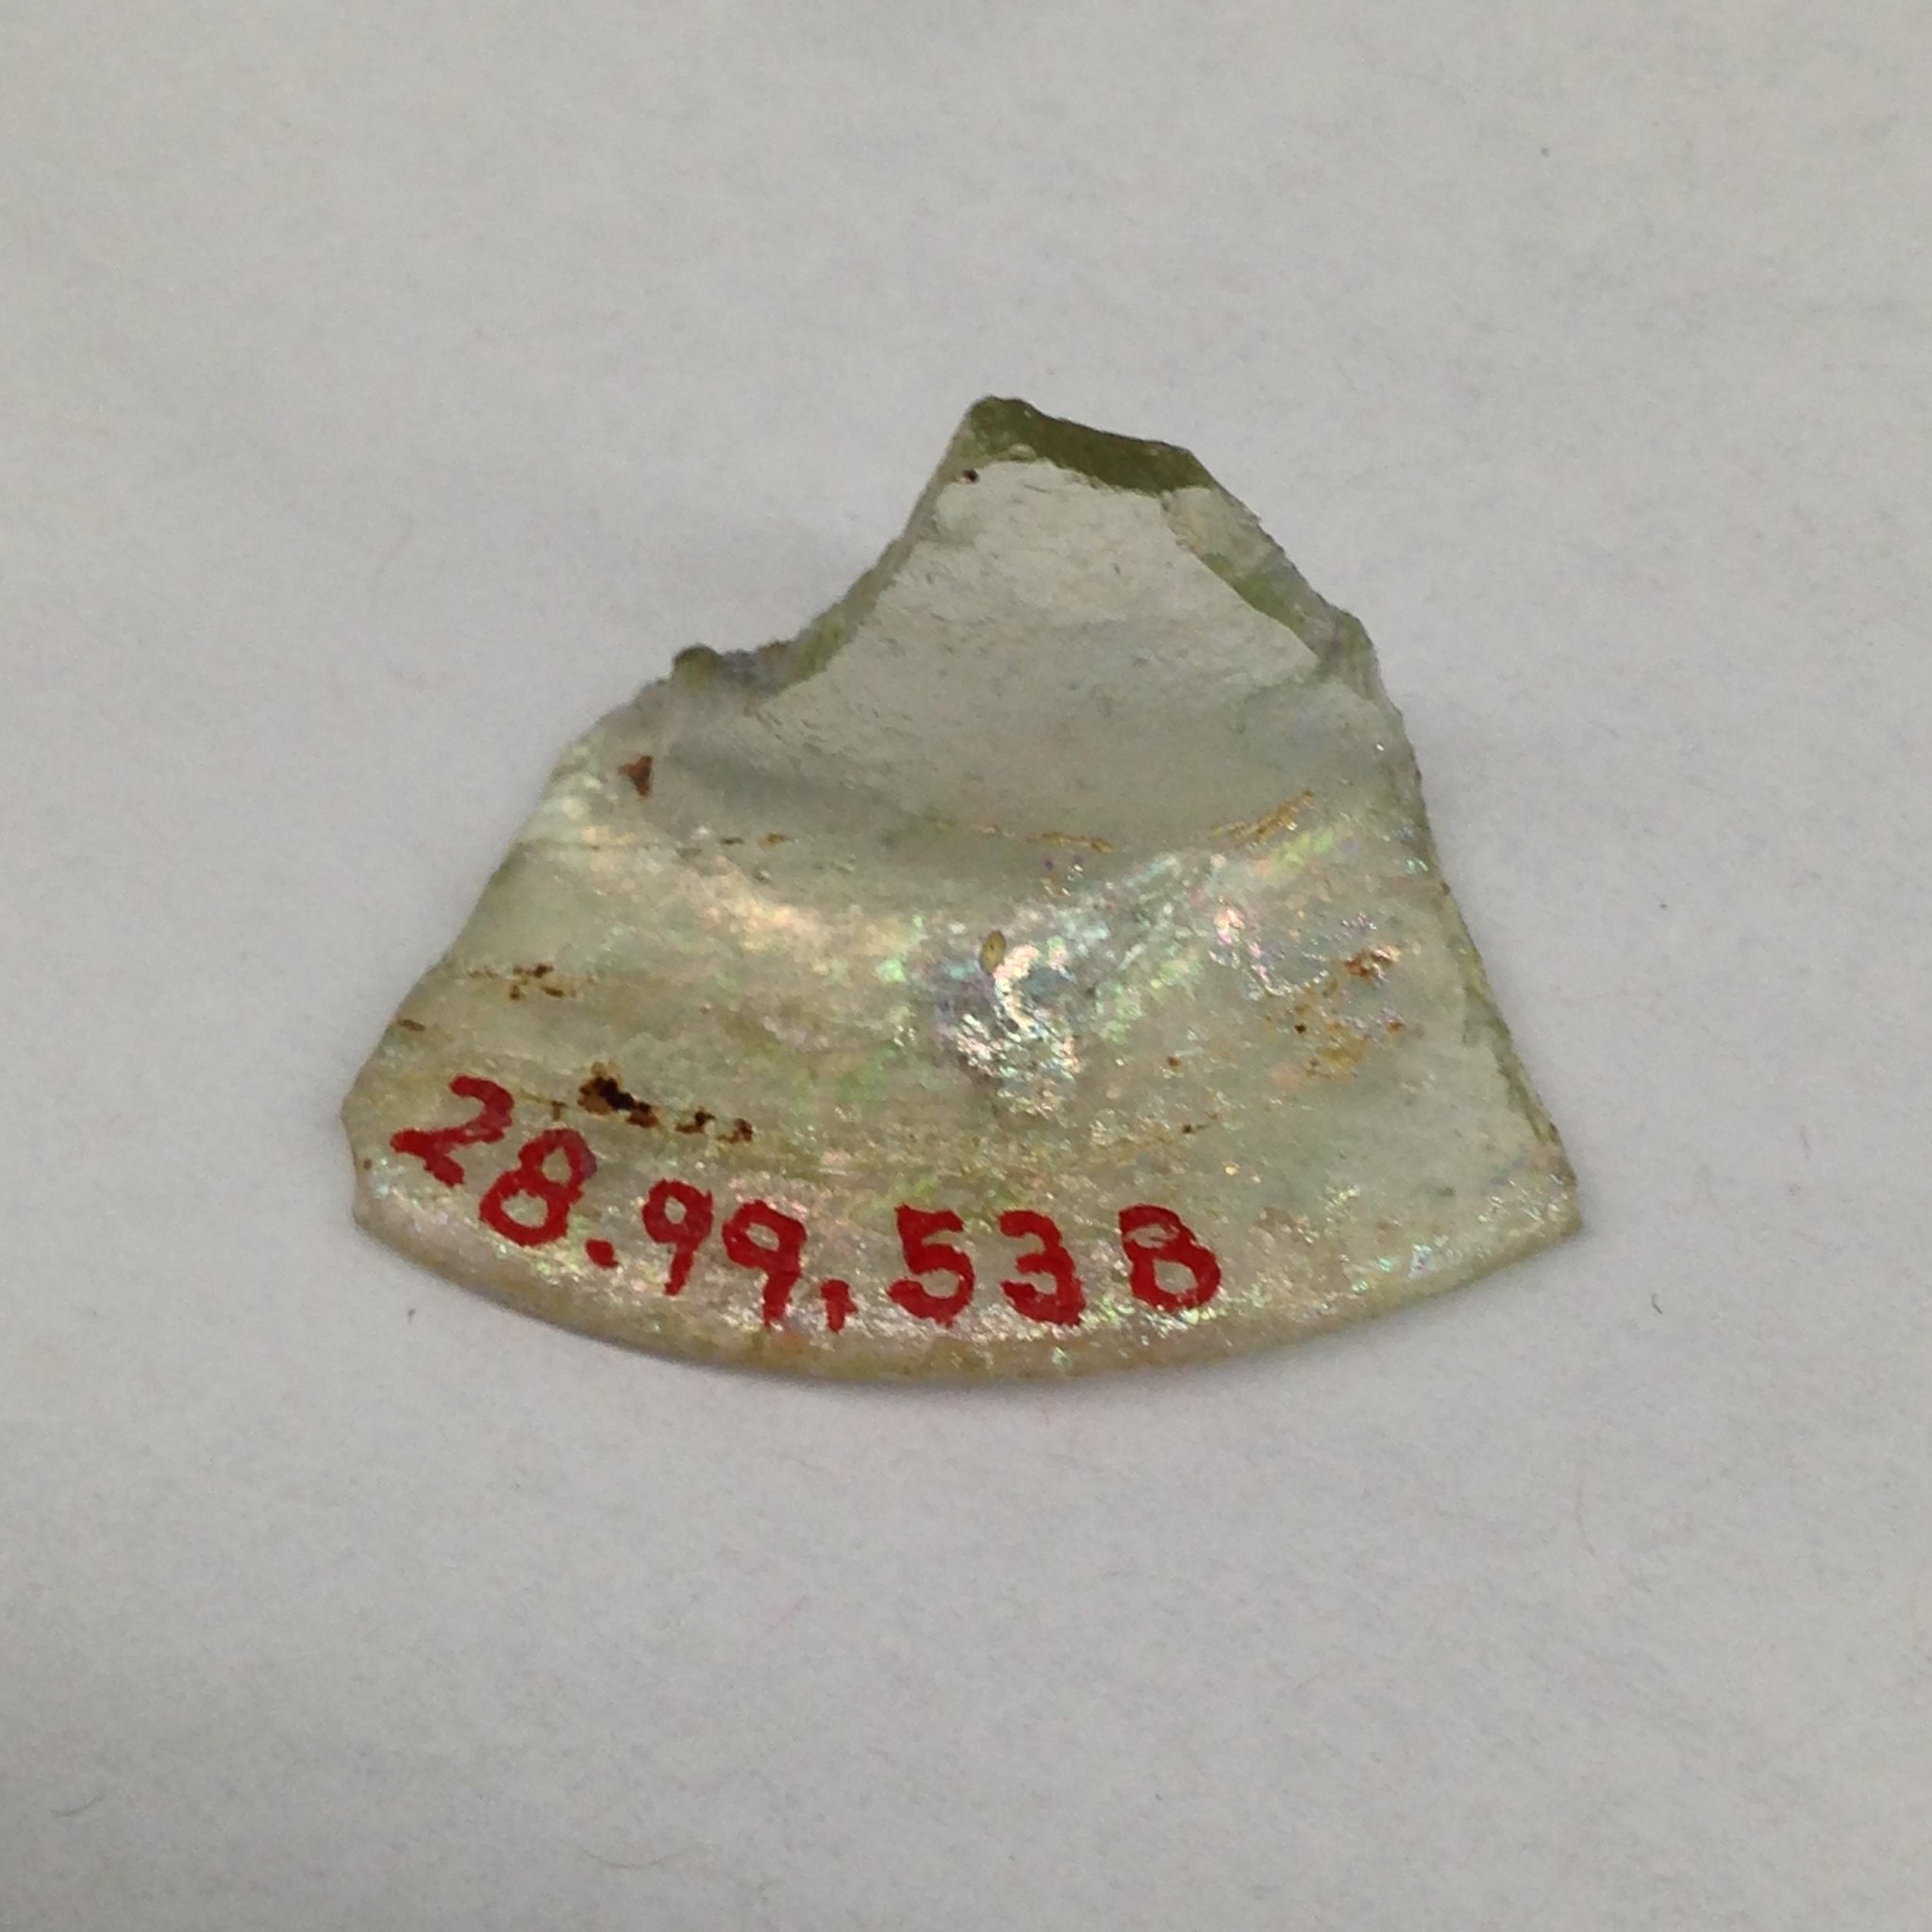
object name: fragment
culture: european or middle eastern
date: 1150-1250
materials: ceramic, glass